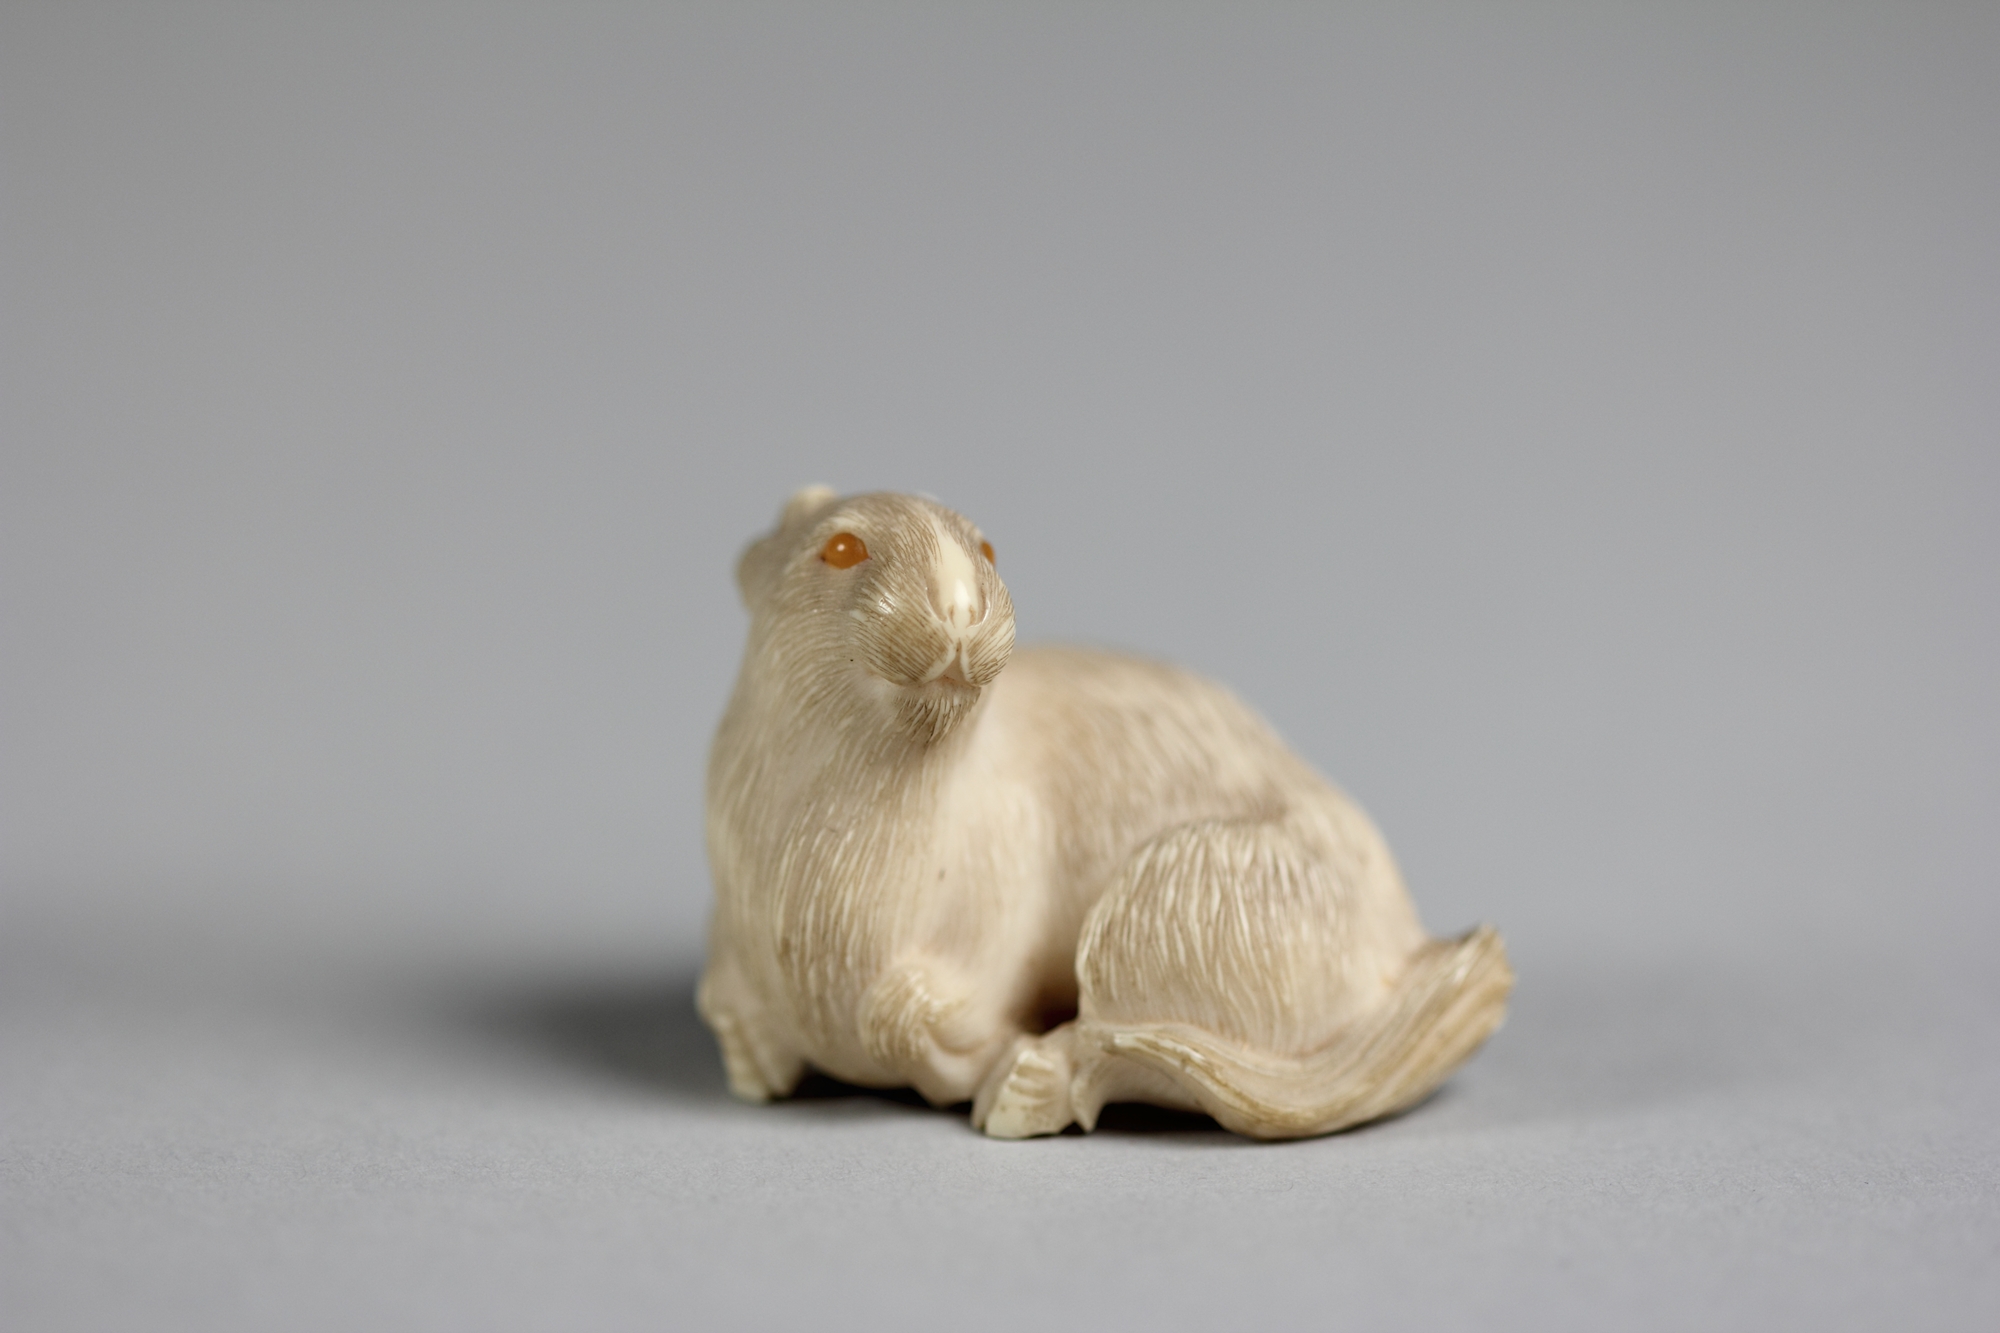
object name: netsuke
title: Goat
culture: japanese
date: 1867-1900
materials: glass, ivory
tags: goats